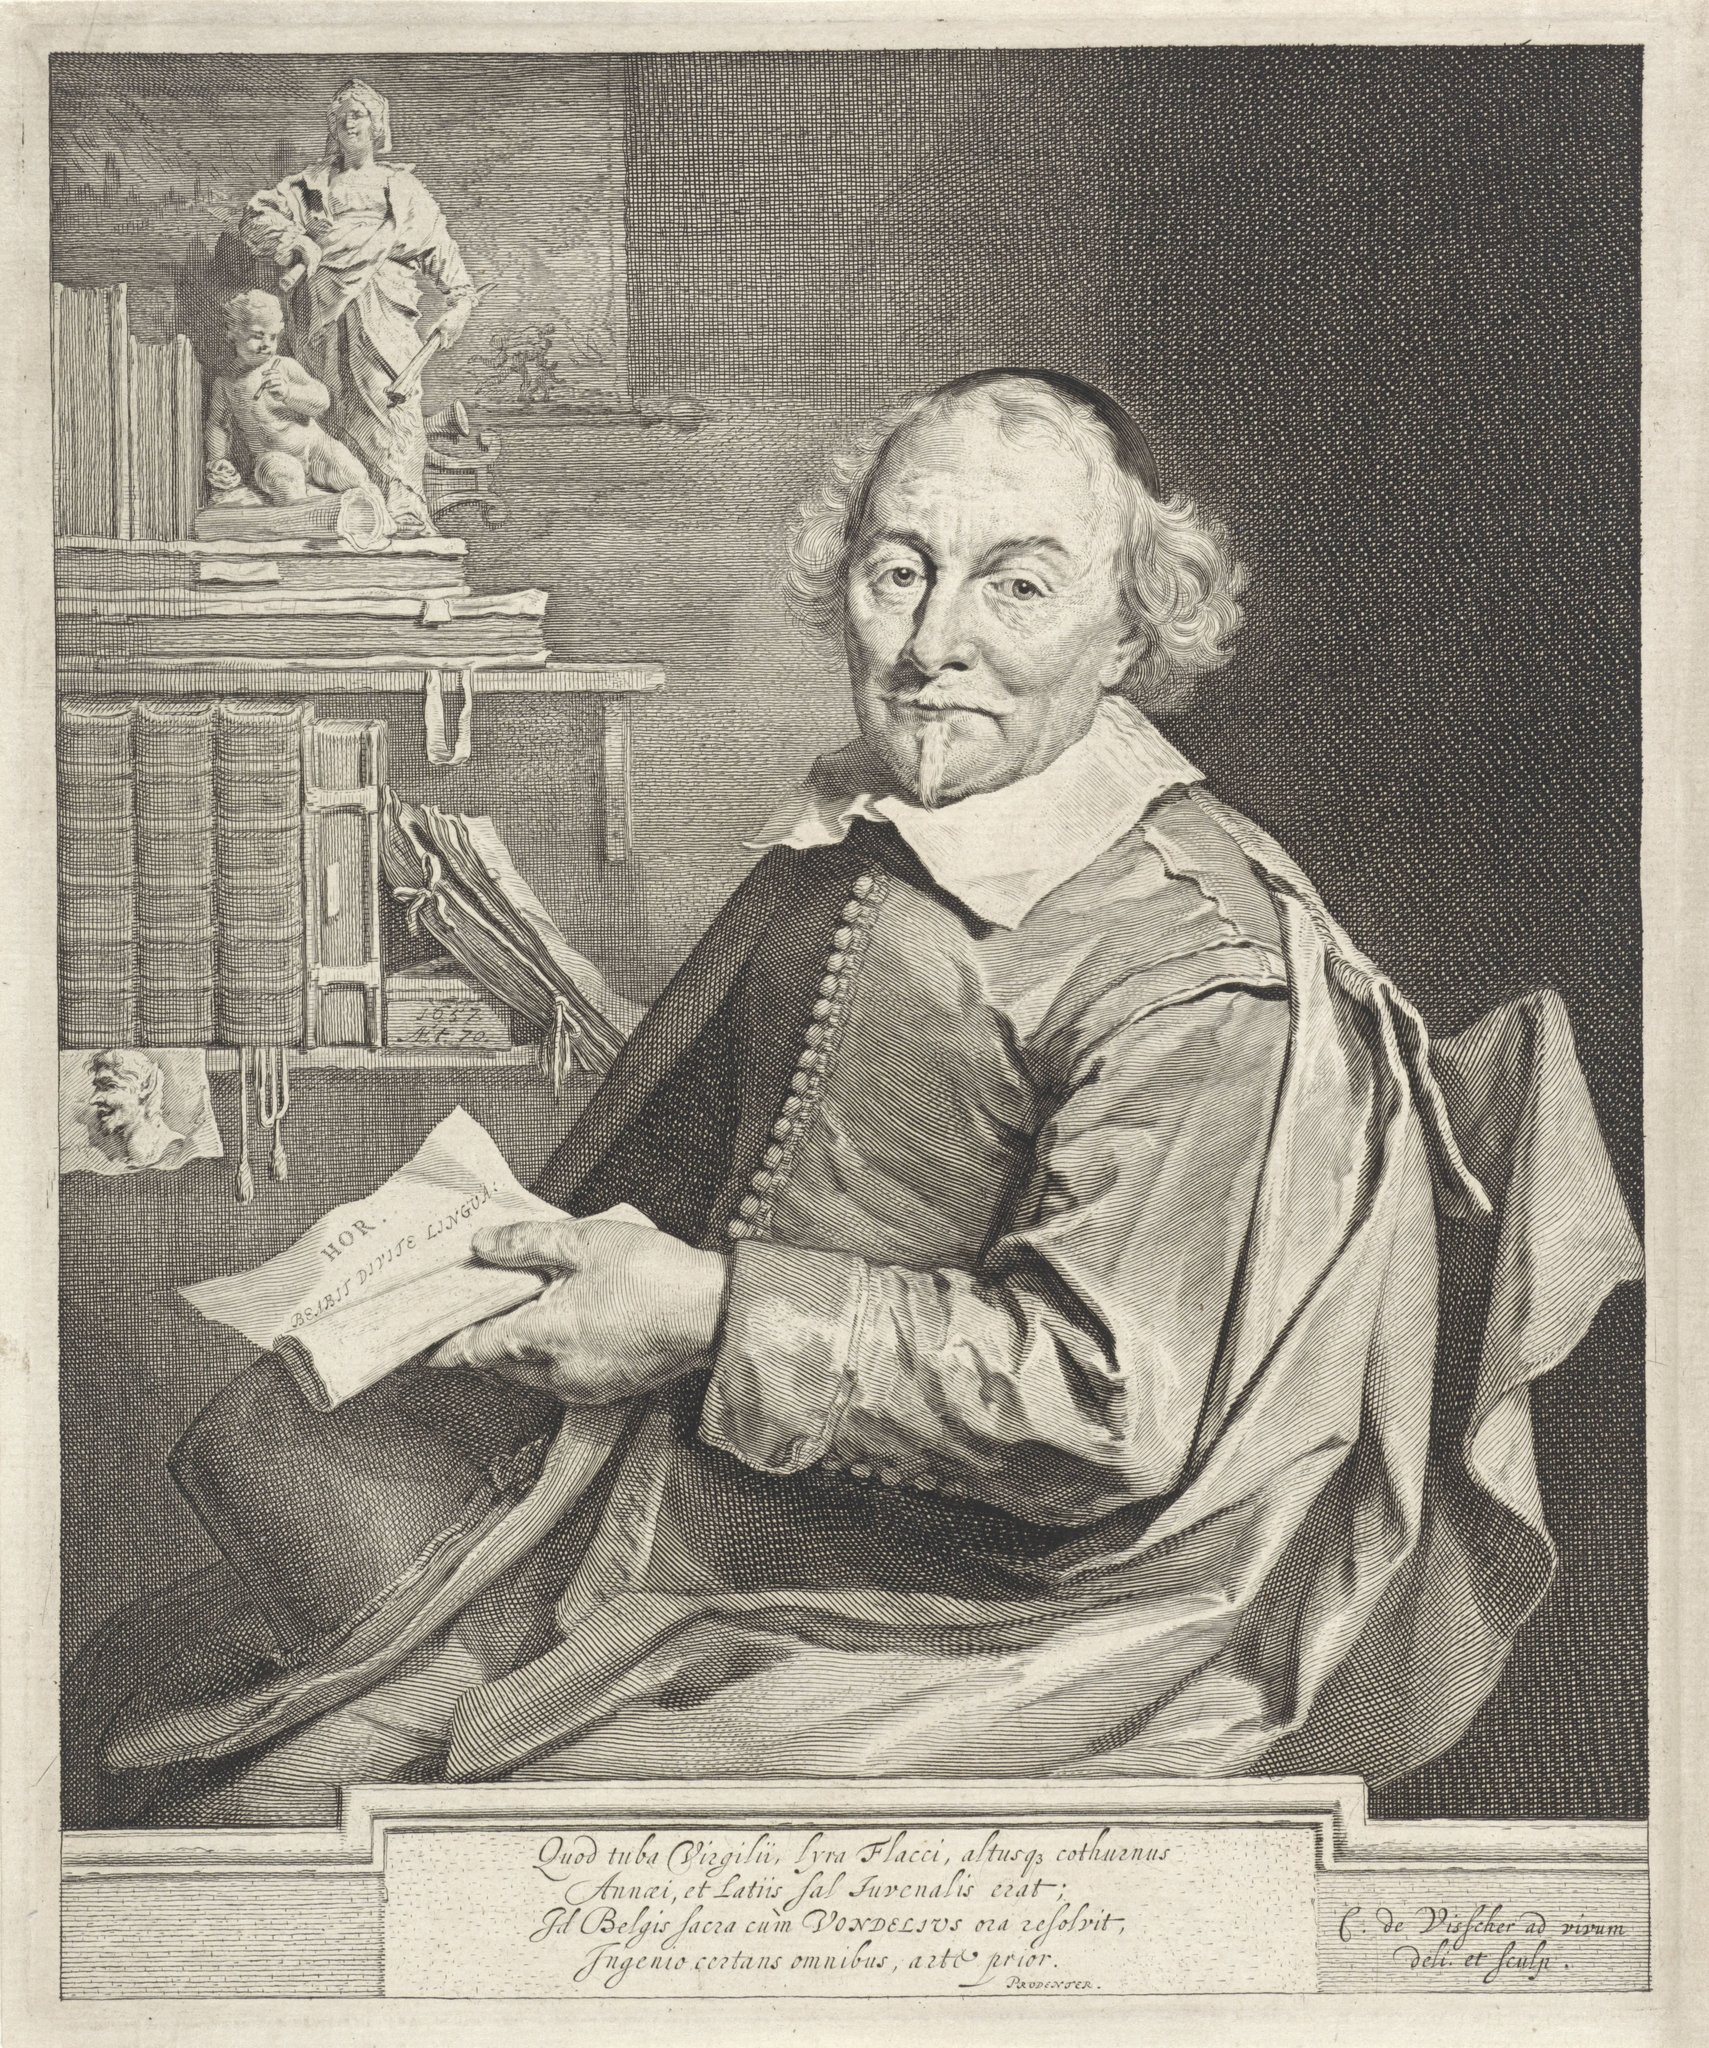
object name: print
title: Portret van Joost van den Vondel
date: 1657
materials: paper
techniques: engraving, etching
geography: haarlem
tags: cologne, amsterdam, joost van den vondel, print, e.g.: engraving, etching, lithograph, head-gear: hat (+ men's clothes), sculpture, cupids: 'amores', 'amoretti', 'putti'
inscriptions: collector's mark: Lugt 2228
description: De schrijver en dichter Joost van den Vondel op 70-jarige leeftijd in zijn werkkamer. Hij draagt een kalot en heeft een beschreven rol papier in zijn hand. Hij zit bij twee planken met boeken en beelden van een vrouw en een putto. Aan de muur hangt een op stokken geslagen prent.